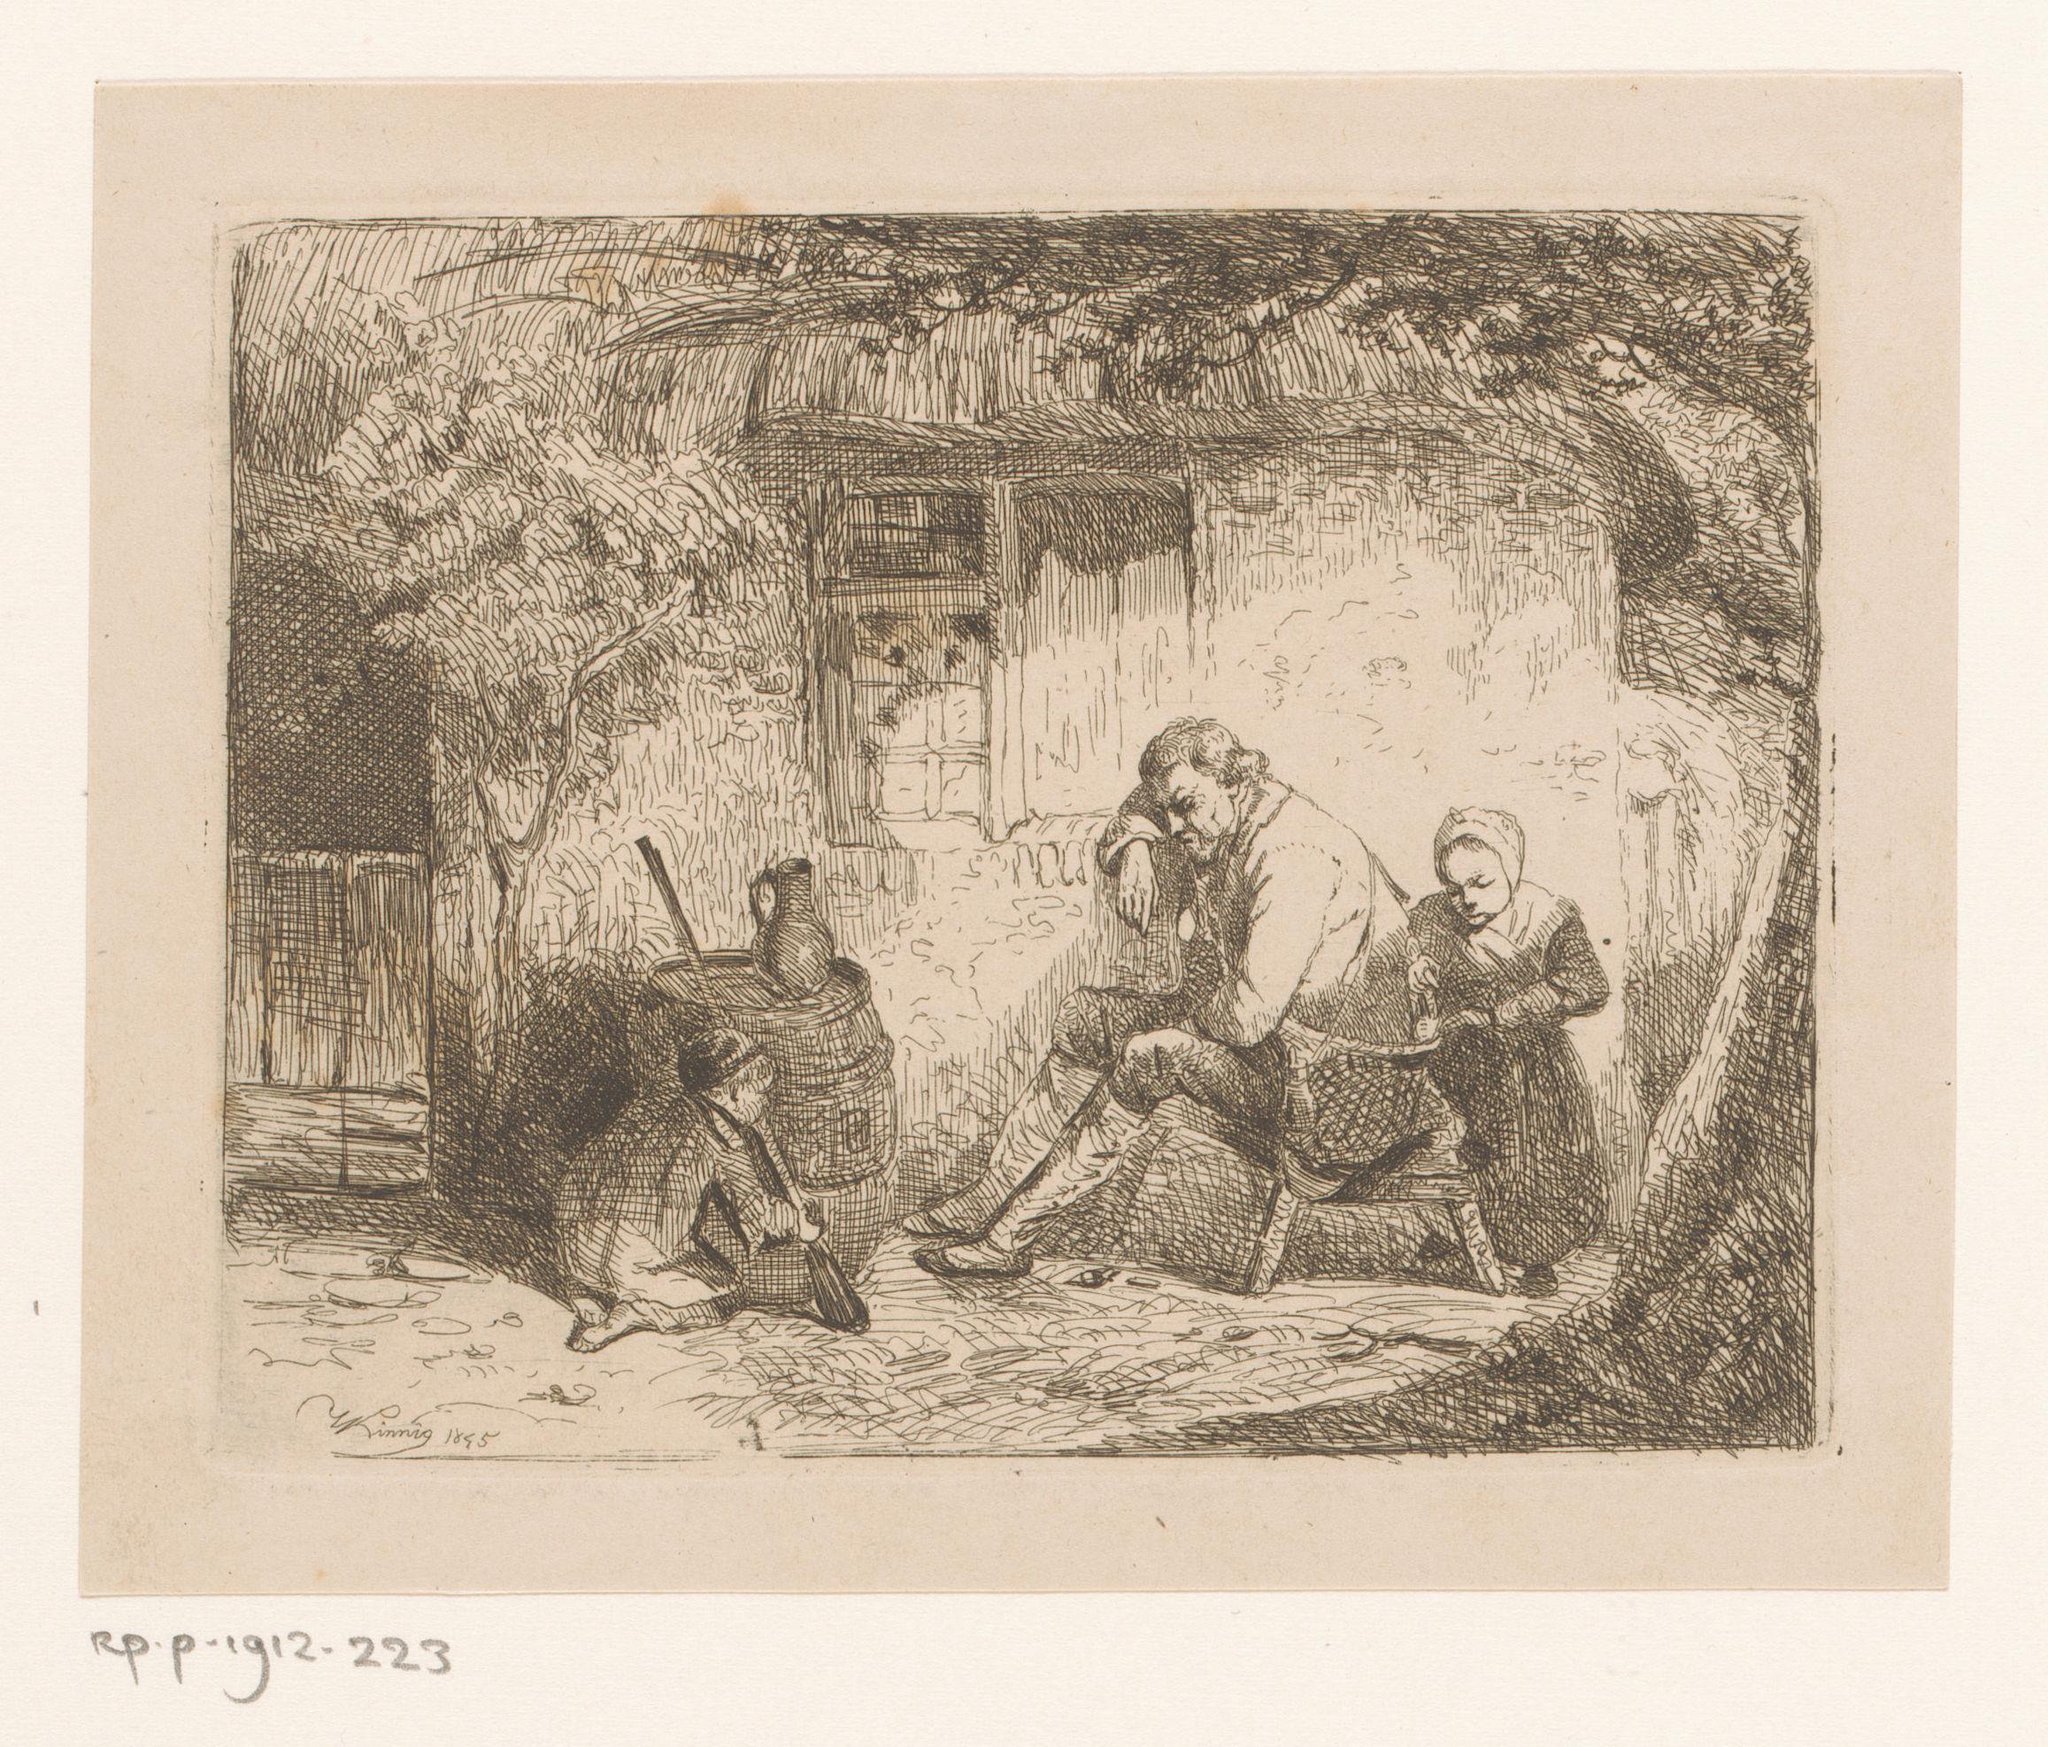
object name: print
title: Jager met twee kinderen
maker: willem linnig (i)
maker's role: print maker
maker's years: 1819-1885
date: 1845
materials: paper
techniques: etching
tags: hunter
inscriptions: collector's mark: Lugt 2228, collector's mark: Lugt 1485